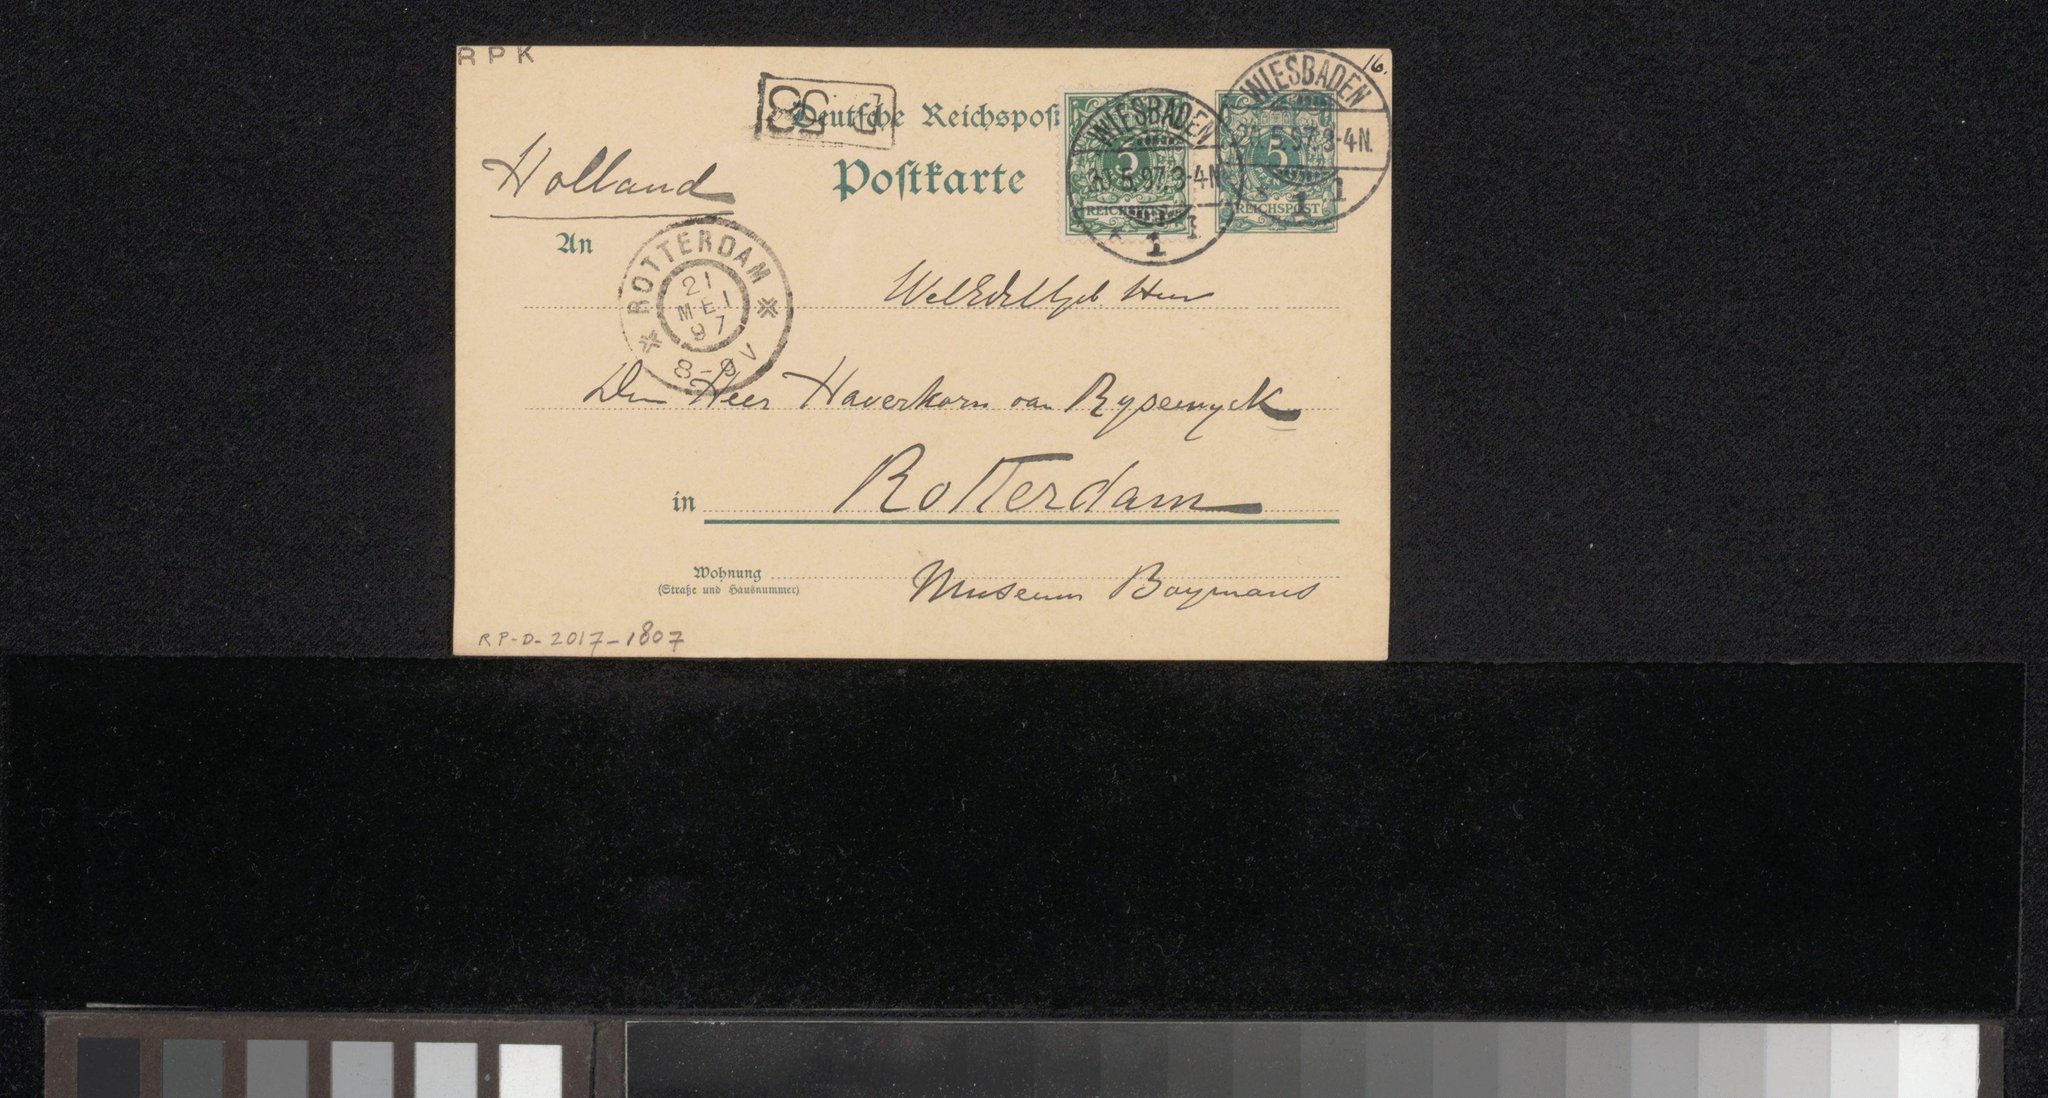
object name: postcard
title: Briefkaart aan Pieter Haverkorn van Rijsewijk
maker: carel nicolaas storm van s-gravesande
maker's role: draughtsman, print maker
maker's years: 1841-1924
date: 1897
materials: cardboard, ink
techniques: pen, writing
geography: wiesbaden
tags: pieter haverkorn van rijsewijk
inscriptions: collector's mark: ‘RPK’